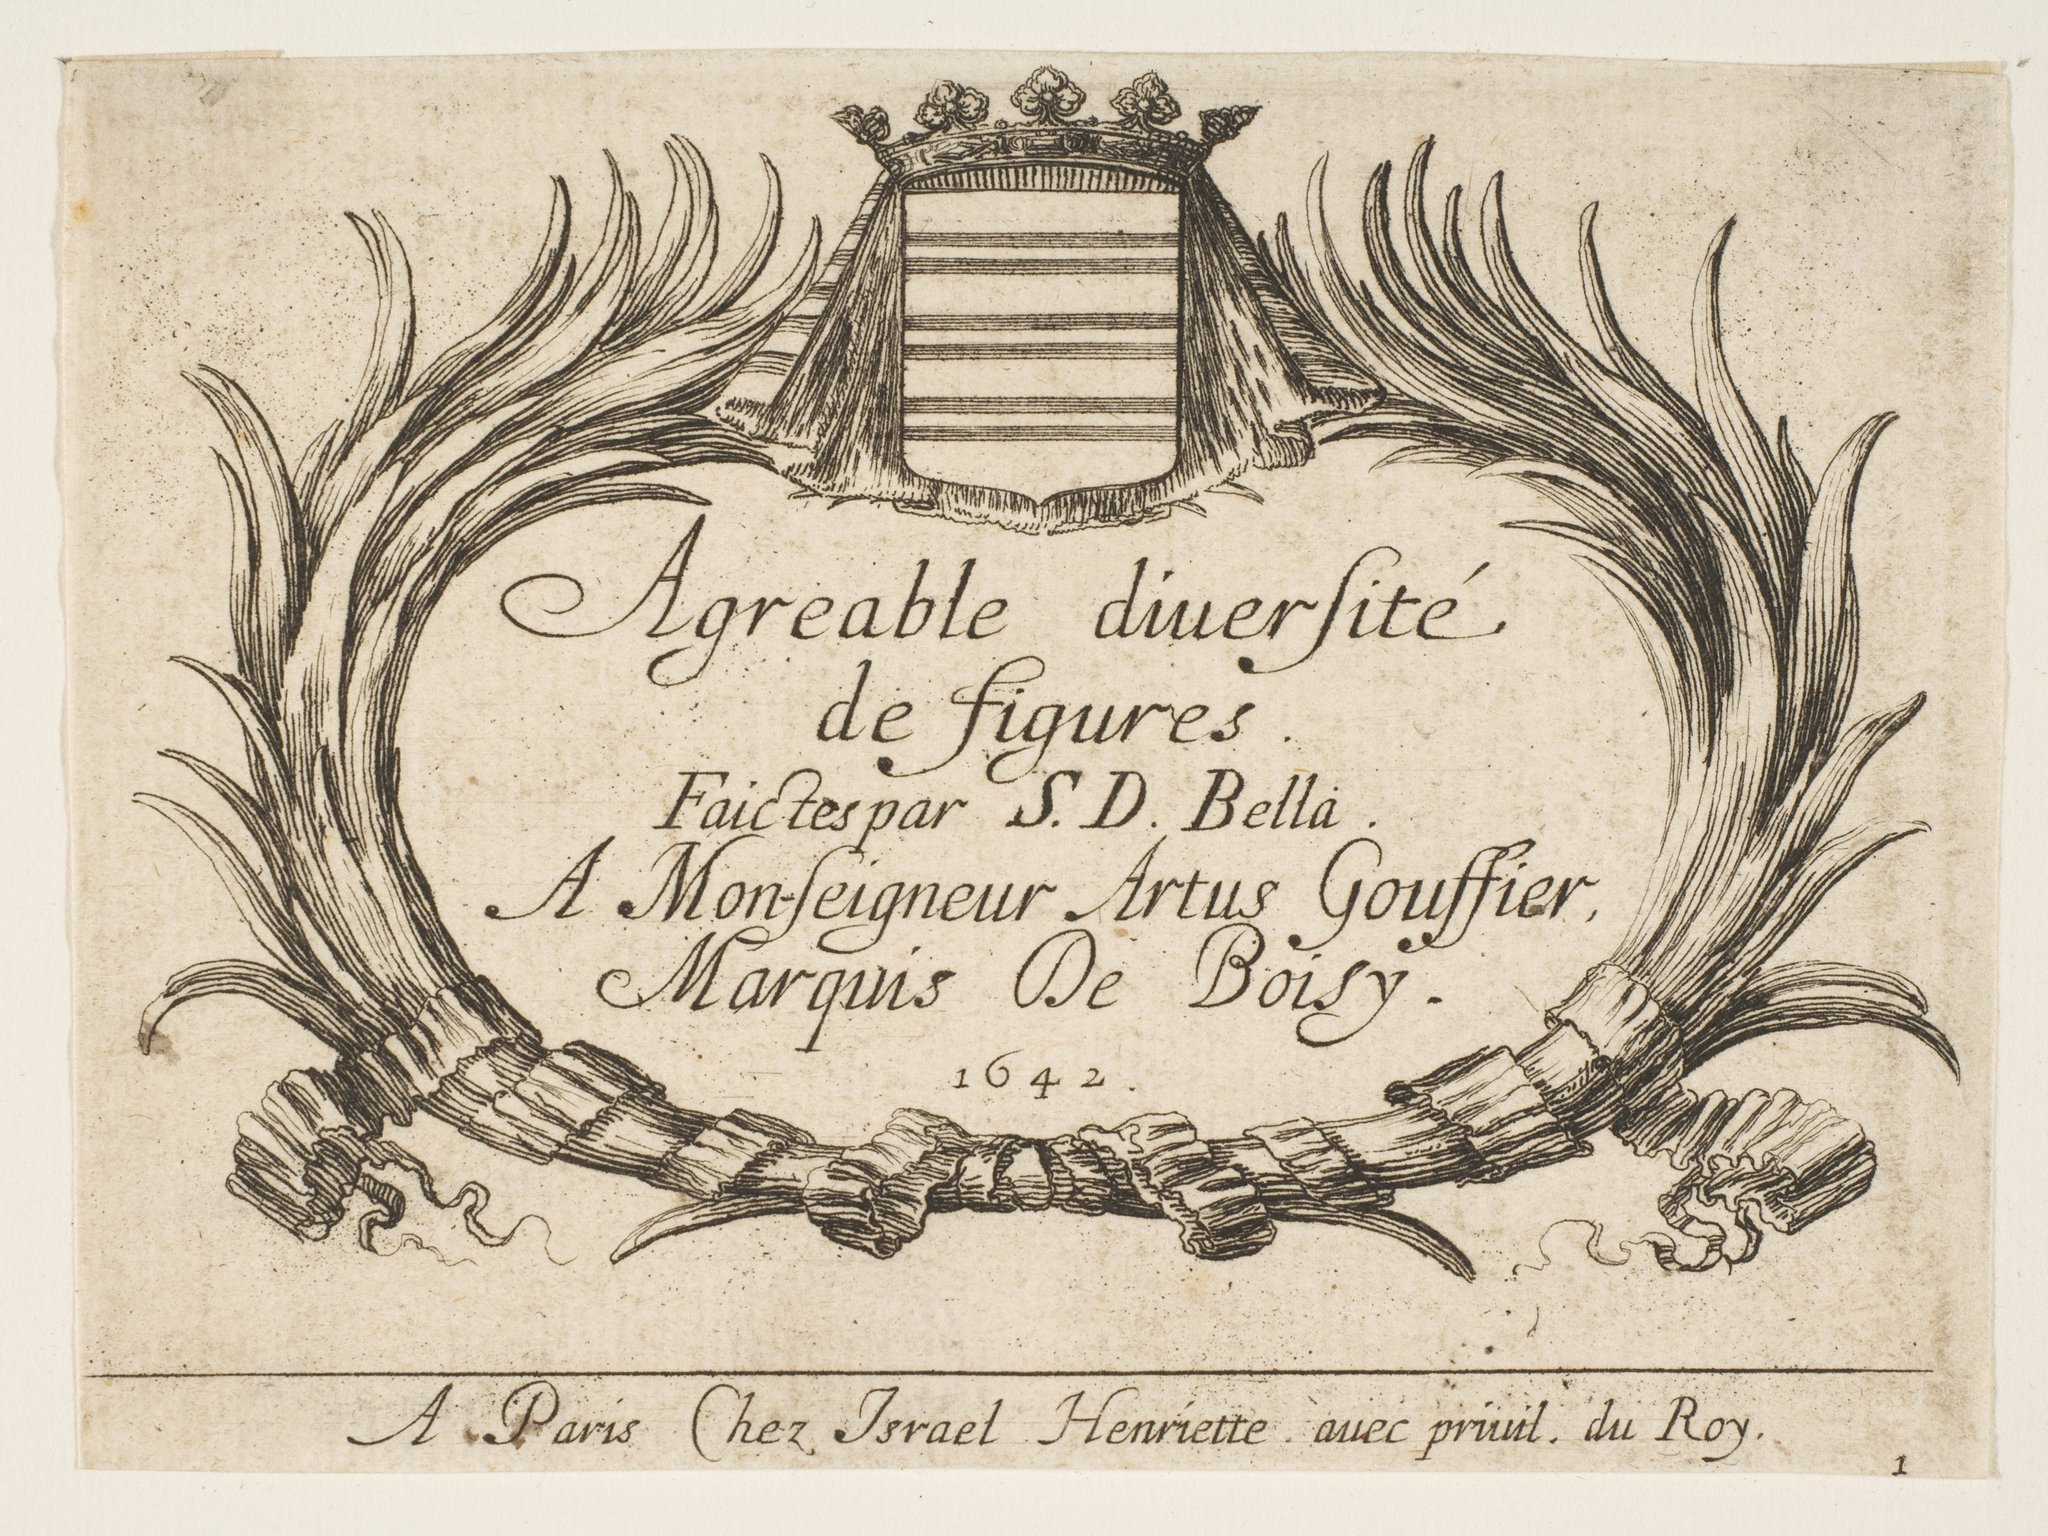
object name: print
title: Two palms and a coat of arms frame the title and dedication, title page and plate 1 for "Various Figures" (Agréable diversité de figures)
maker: stefano della bella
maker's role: artist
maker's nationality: italian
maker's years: 1610-1664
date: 1642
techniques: etching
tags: leaves,coat of arms